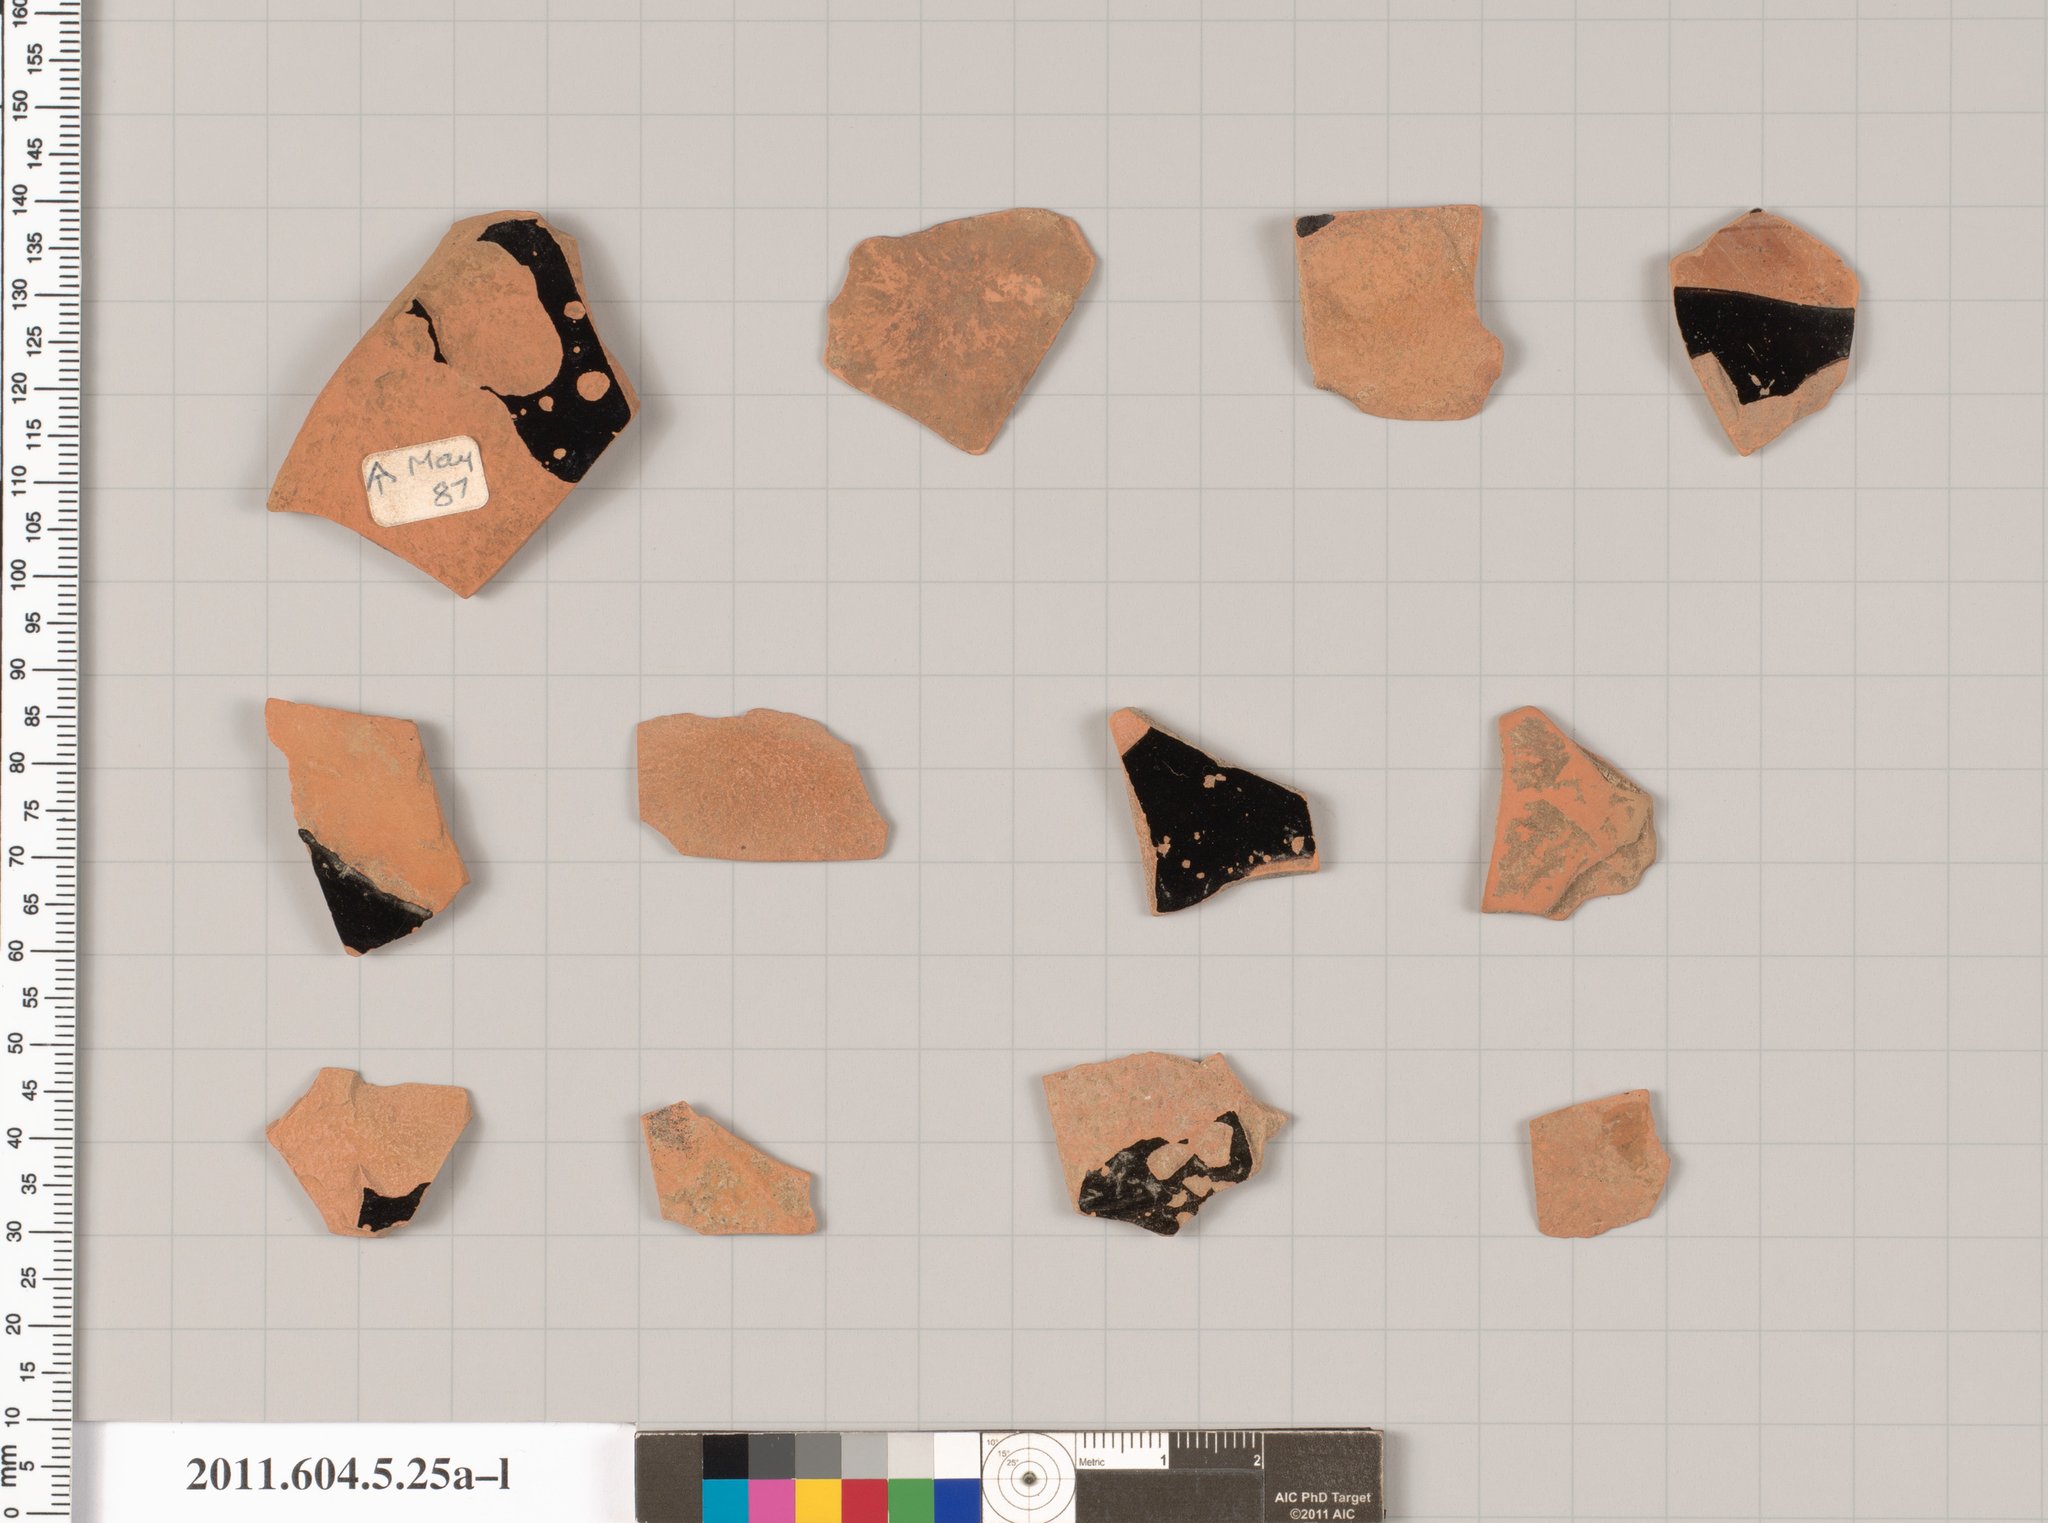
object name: kylix fragment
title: Terracotta fragments of kylikes (drinking cups)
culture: greek, attic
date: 500-401 BCE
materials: terracotta